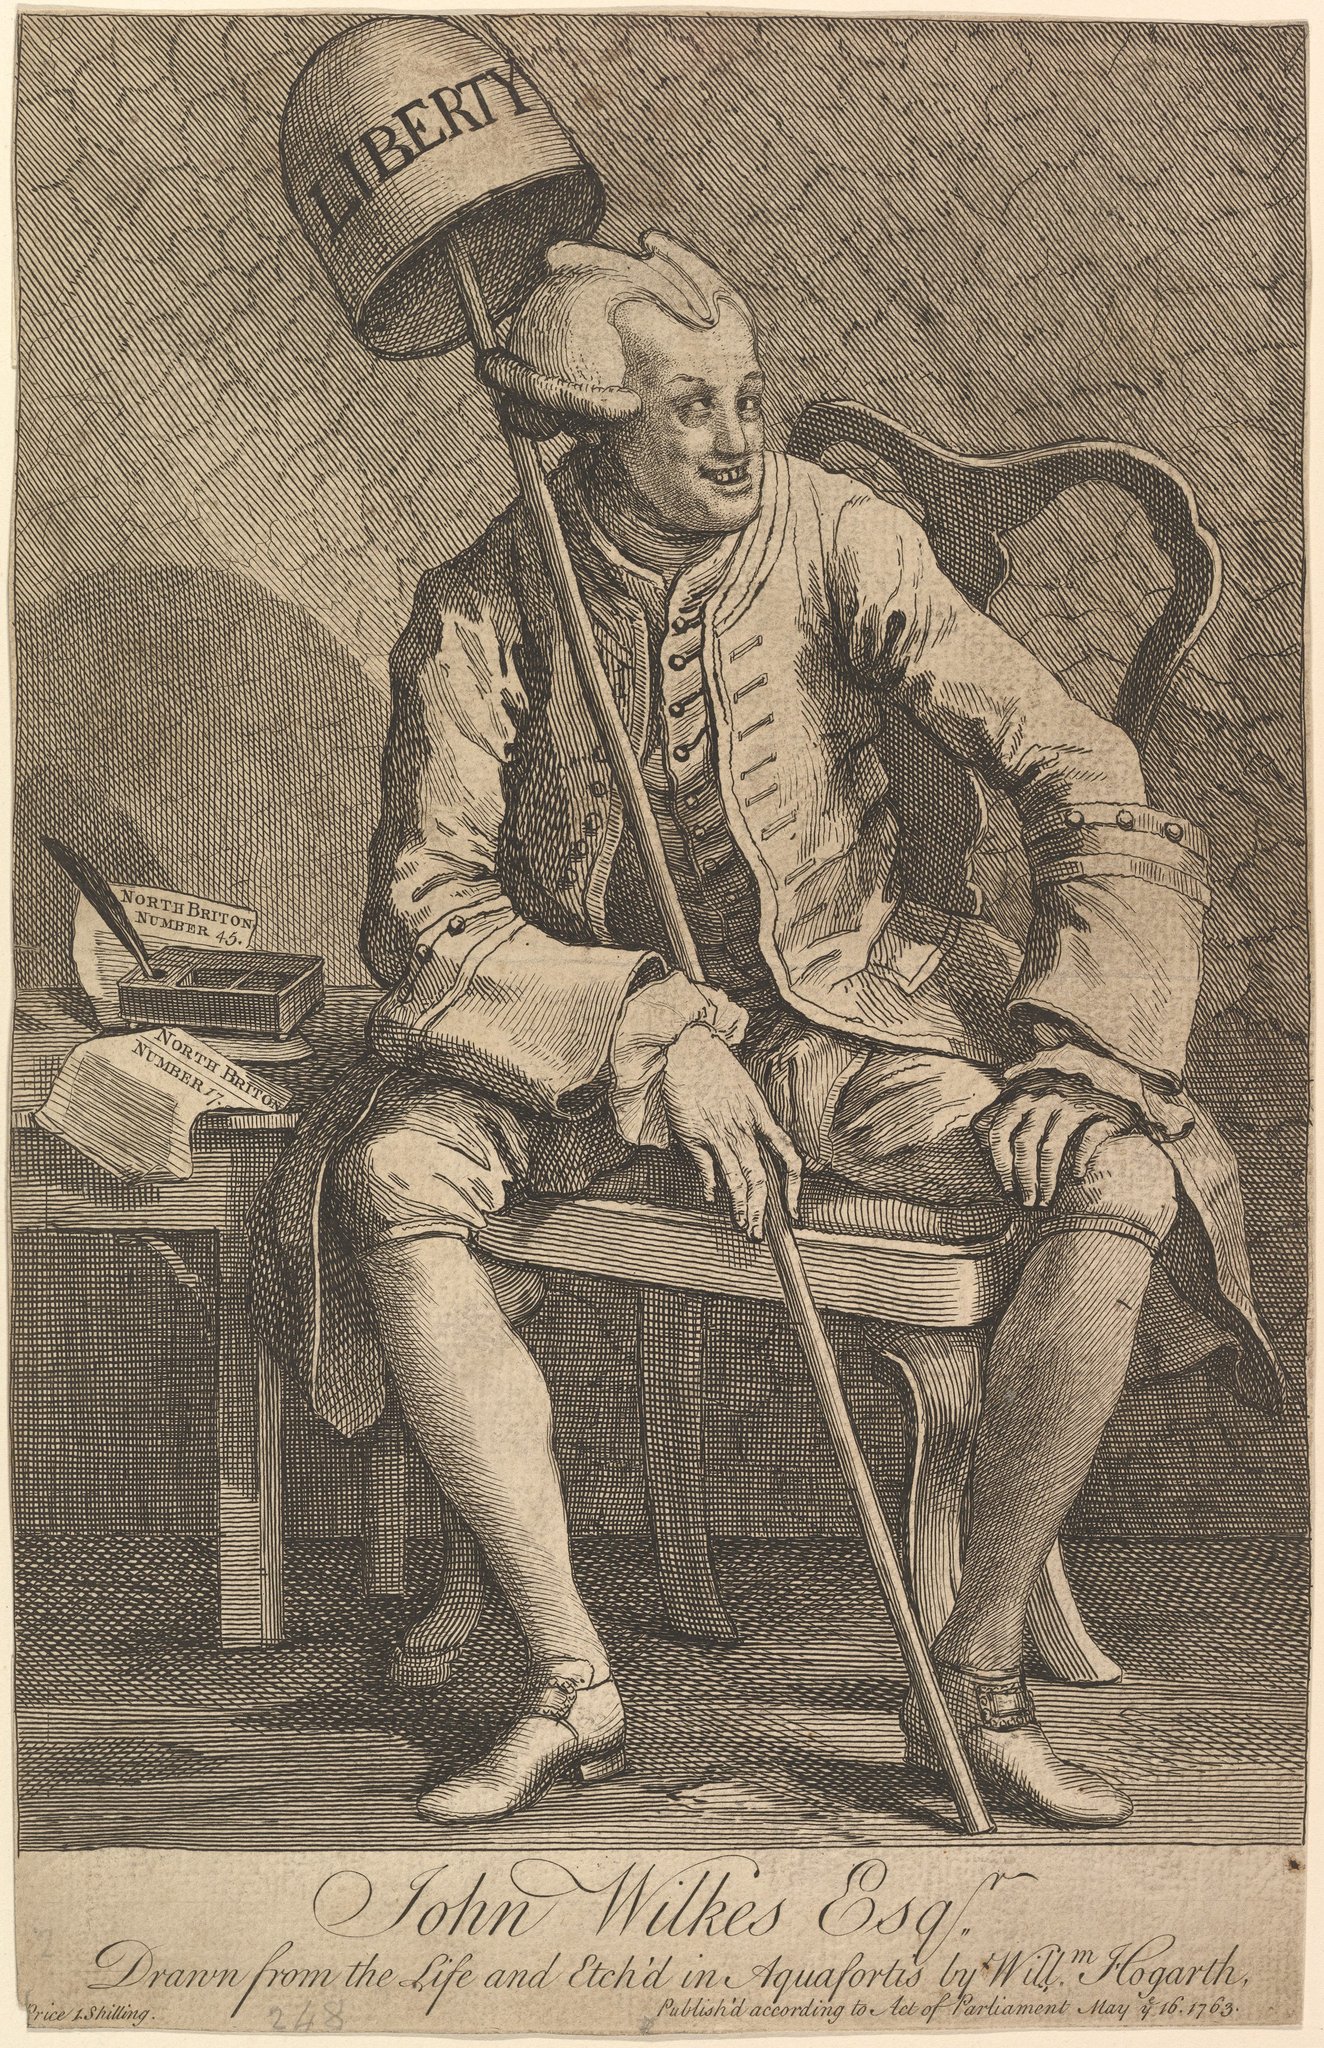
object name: print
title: John Wilkes, Esq.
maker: william hogarth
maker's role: artist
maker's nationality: british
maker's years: 1697-1764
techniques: engraving, etching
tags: men